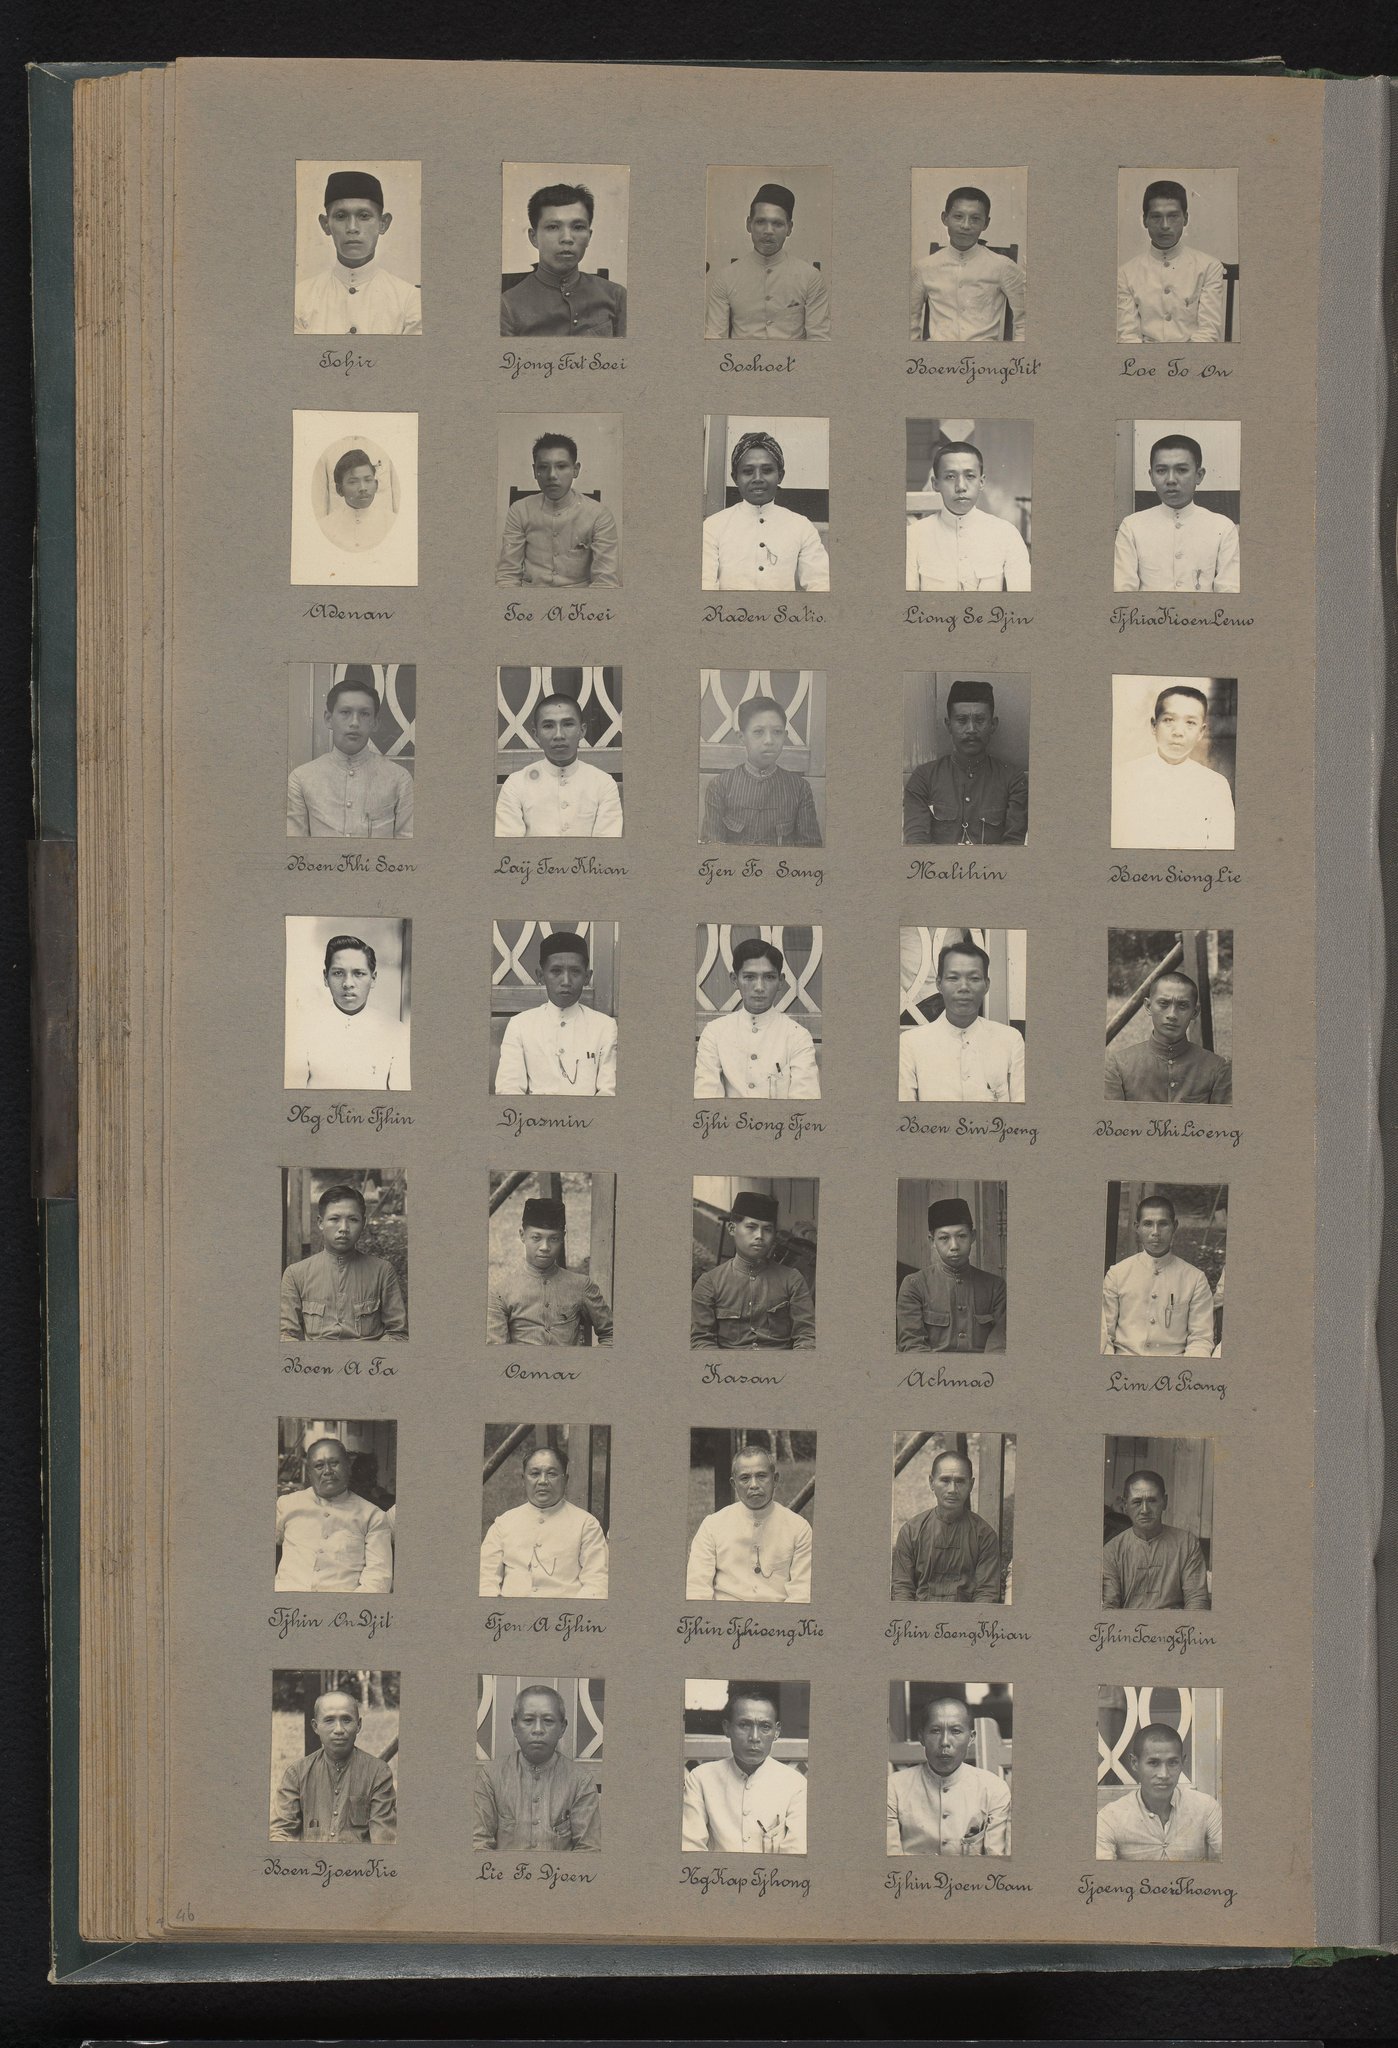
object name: album leaf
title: Pasfoto's van personeel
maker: Anonymous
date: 1914-1919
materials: cardboard, photographic support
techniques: gelatin silver print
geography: bangka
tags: robert julius boers, colonial system, mining, historical persons, industries ~ metal (+ men (labourers))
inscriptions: inscription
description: Albumblad met 35 kleine pasfoto's van personeel werkzaam bij de Banka-tinwinning te Soengeiliat-Merawang. Portretten van mannen, zonder aanduiding van functie. Onder de foto's de naam van de geportretteerde. Onderdeel van het fotoalbum aangeboden aan Robert Julius Boers bij zijn vertrek naar Nederland in 1919 door het personeel van de Banka-tinwinning.